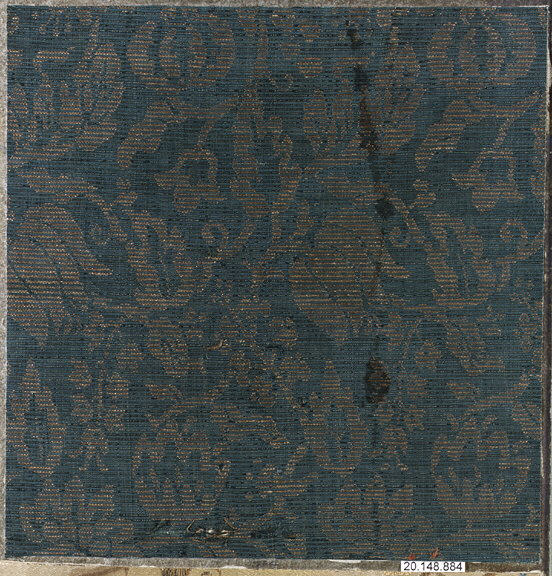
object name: piece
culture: japanese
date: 1601-1700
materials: silk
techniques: compound weave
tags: flowers,leaves